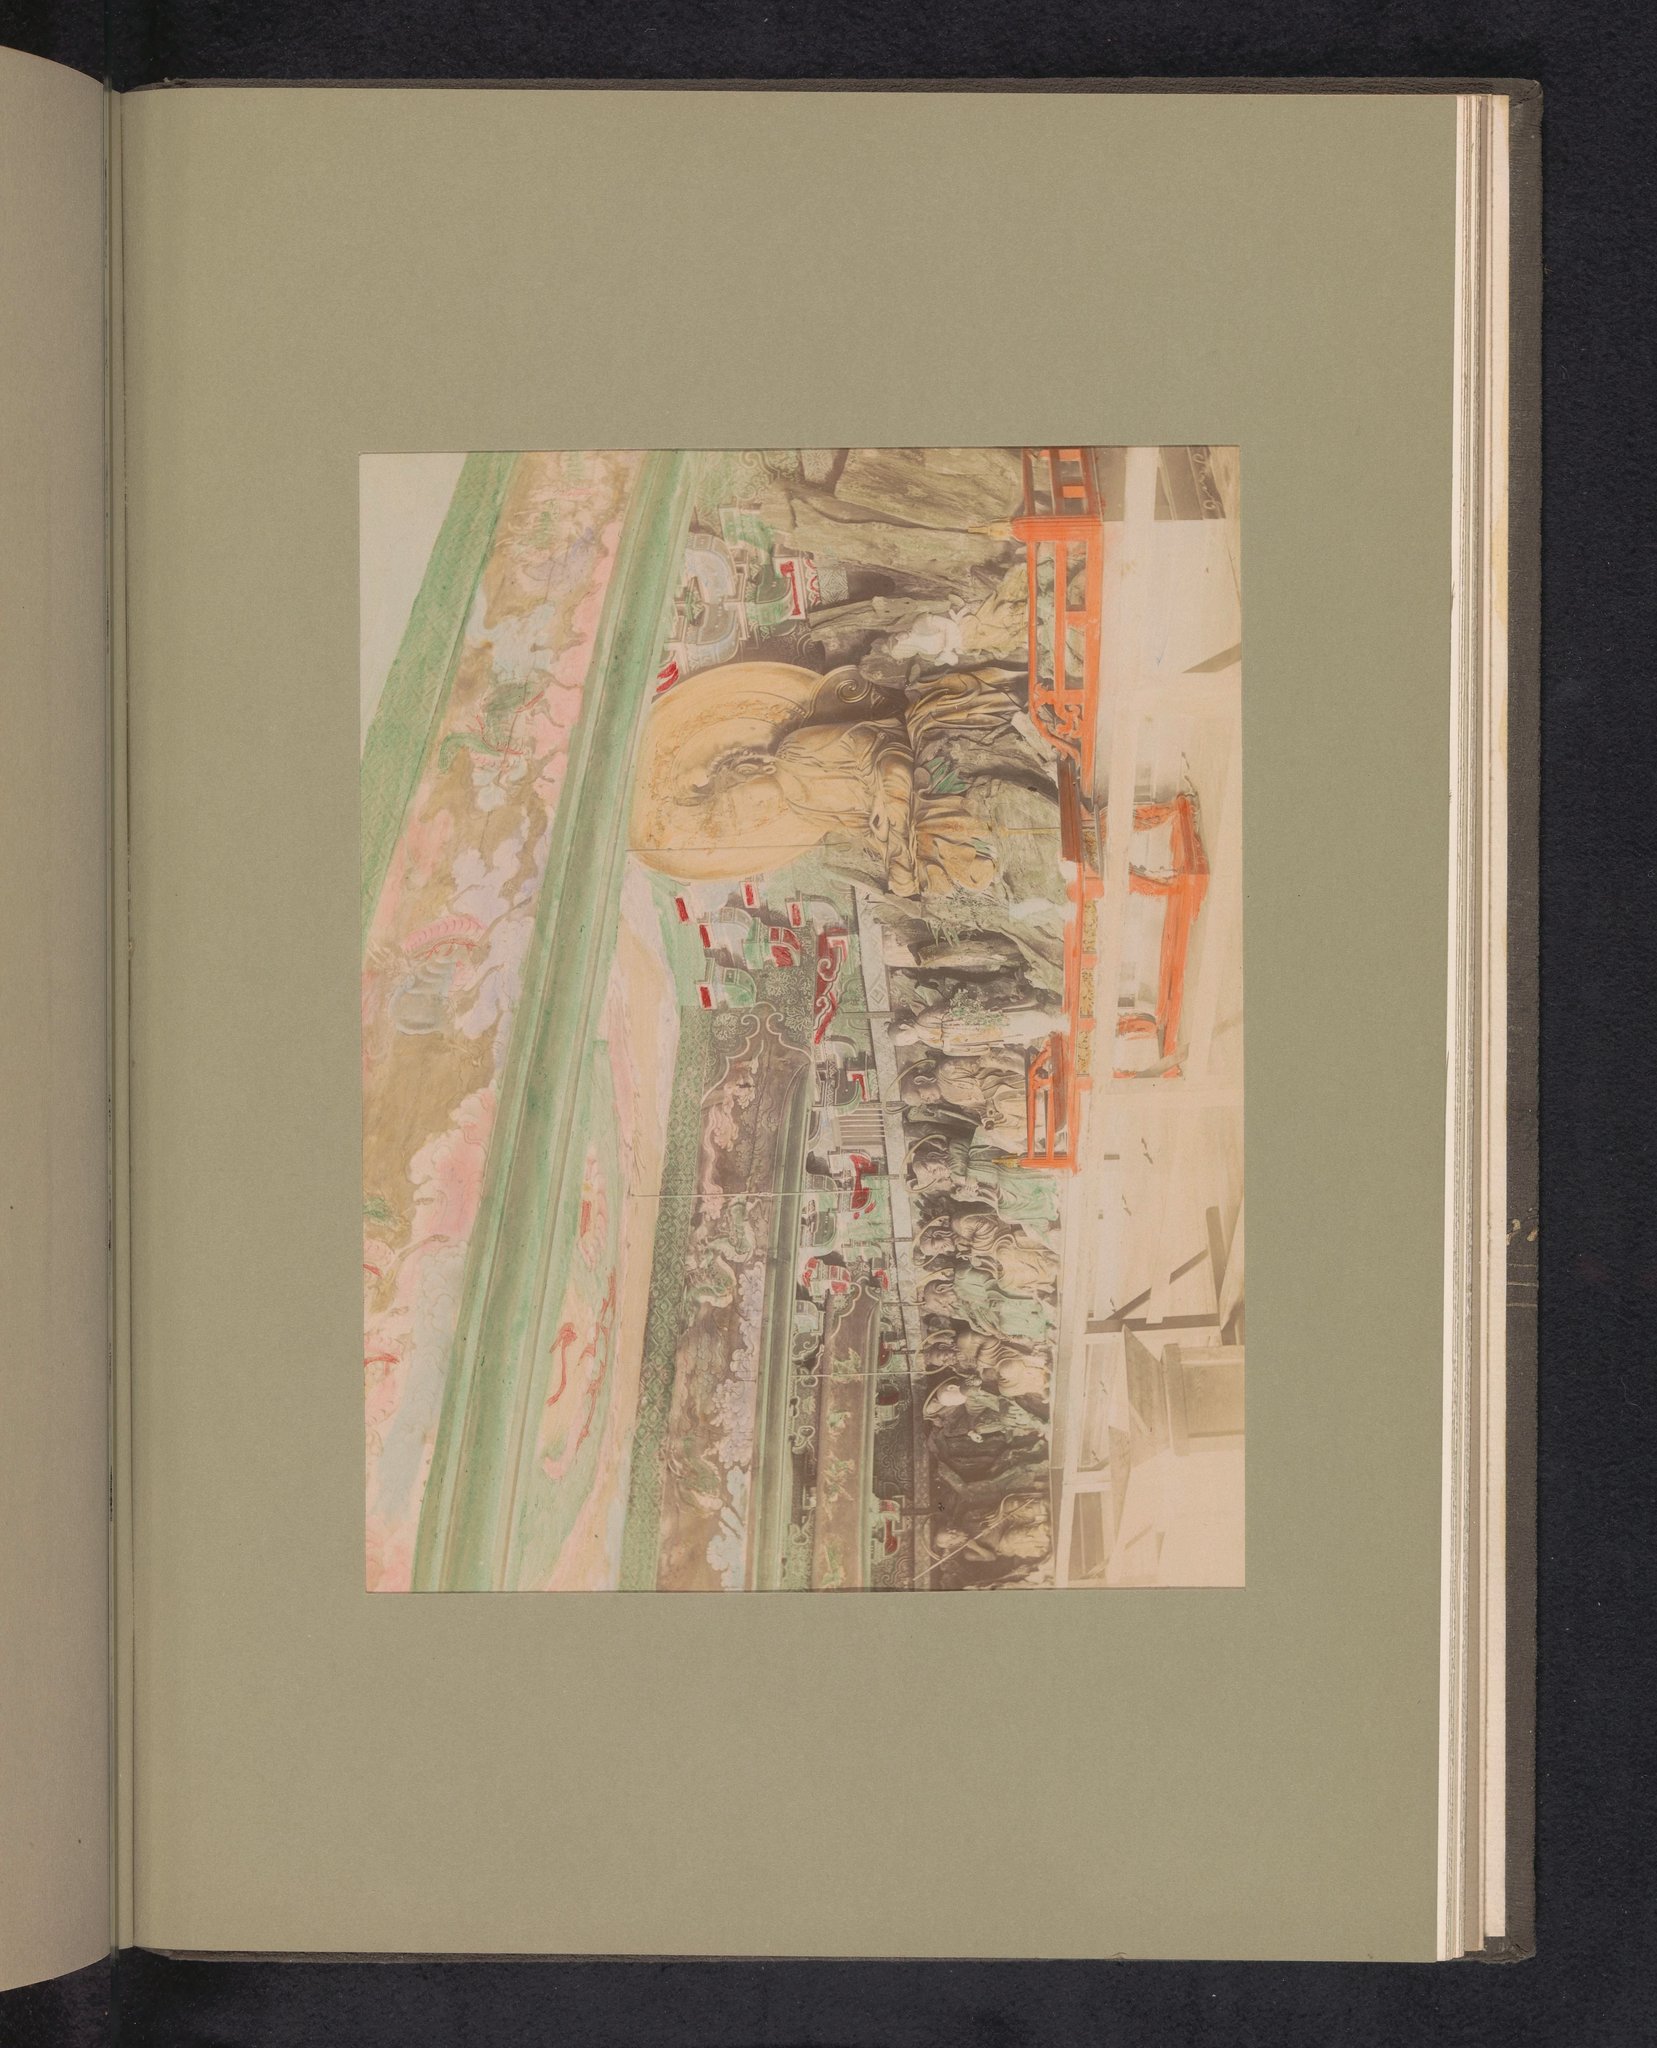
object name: photograph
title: Sculpturen in de tempel Chion-in te Kyoto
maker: Anonymous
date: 1887-1897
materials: photographic support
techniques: albumen print, hand coloring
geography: japan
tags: temple, shrine ~ hinduism, buddhism, jainism, sculpture, interior ~ representation of a building, buddha, founder of buddhism